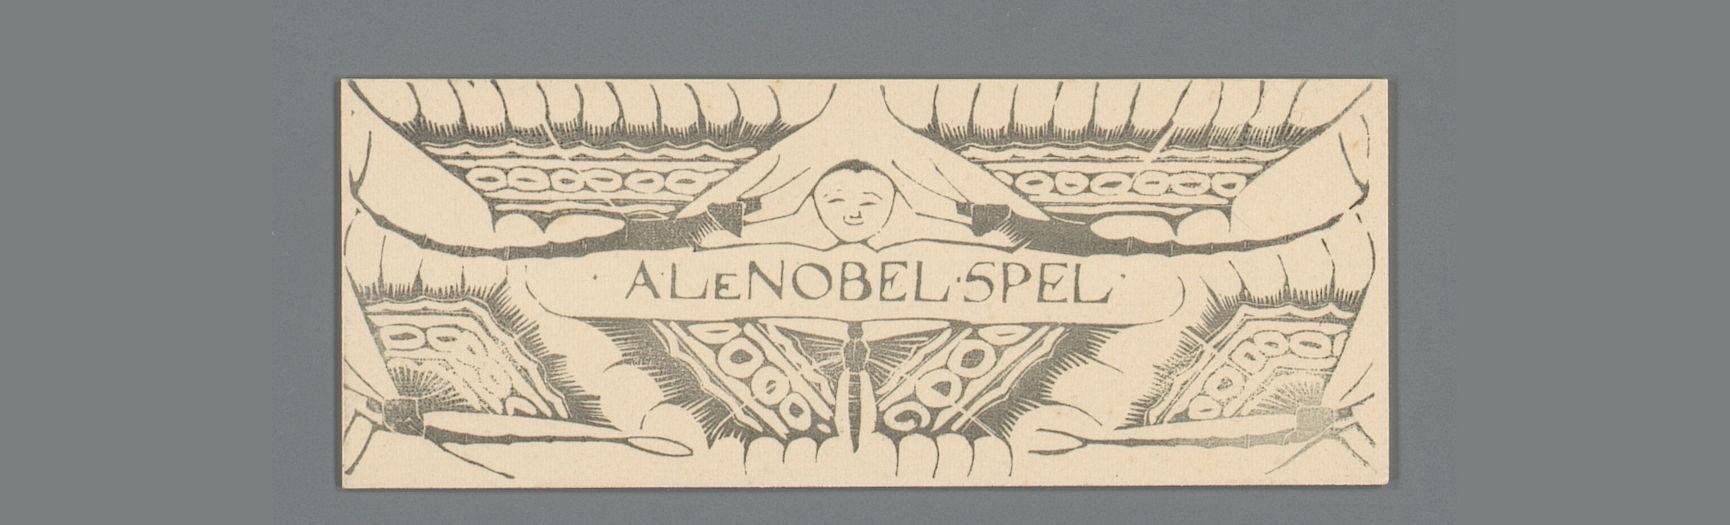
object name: visiting card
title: Visitekaart van Adriana le Nobel-Spel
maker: mathieu lauweriks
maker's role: designer, draughtsman, print maker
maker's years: 1864-1932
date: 1874-1932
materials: paper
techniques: woodcut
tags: hoorn (north holland), ornaments ~ art, visiting-card, calling-card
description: Een decoratief kader met insecten en een gezicht rond de naam 'A. Le Nobel-Spel'.